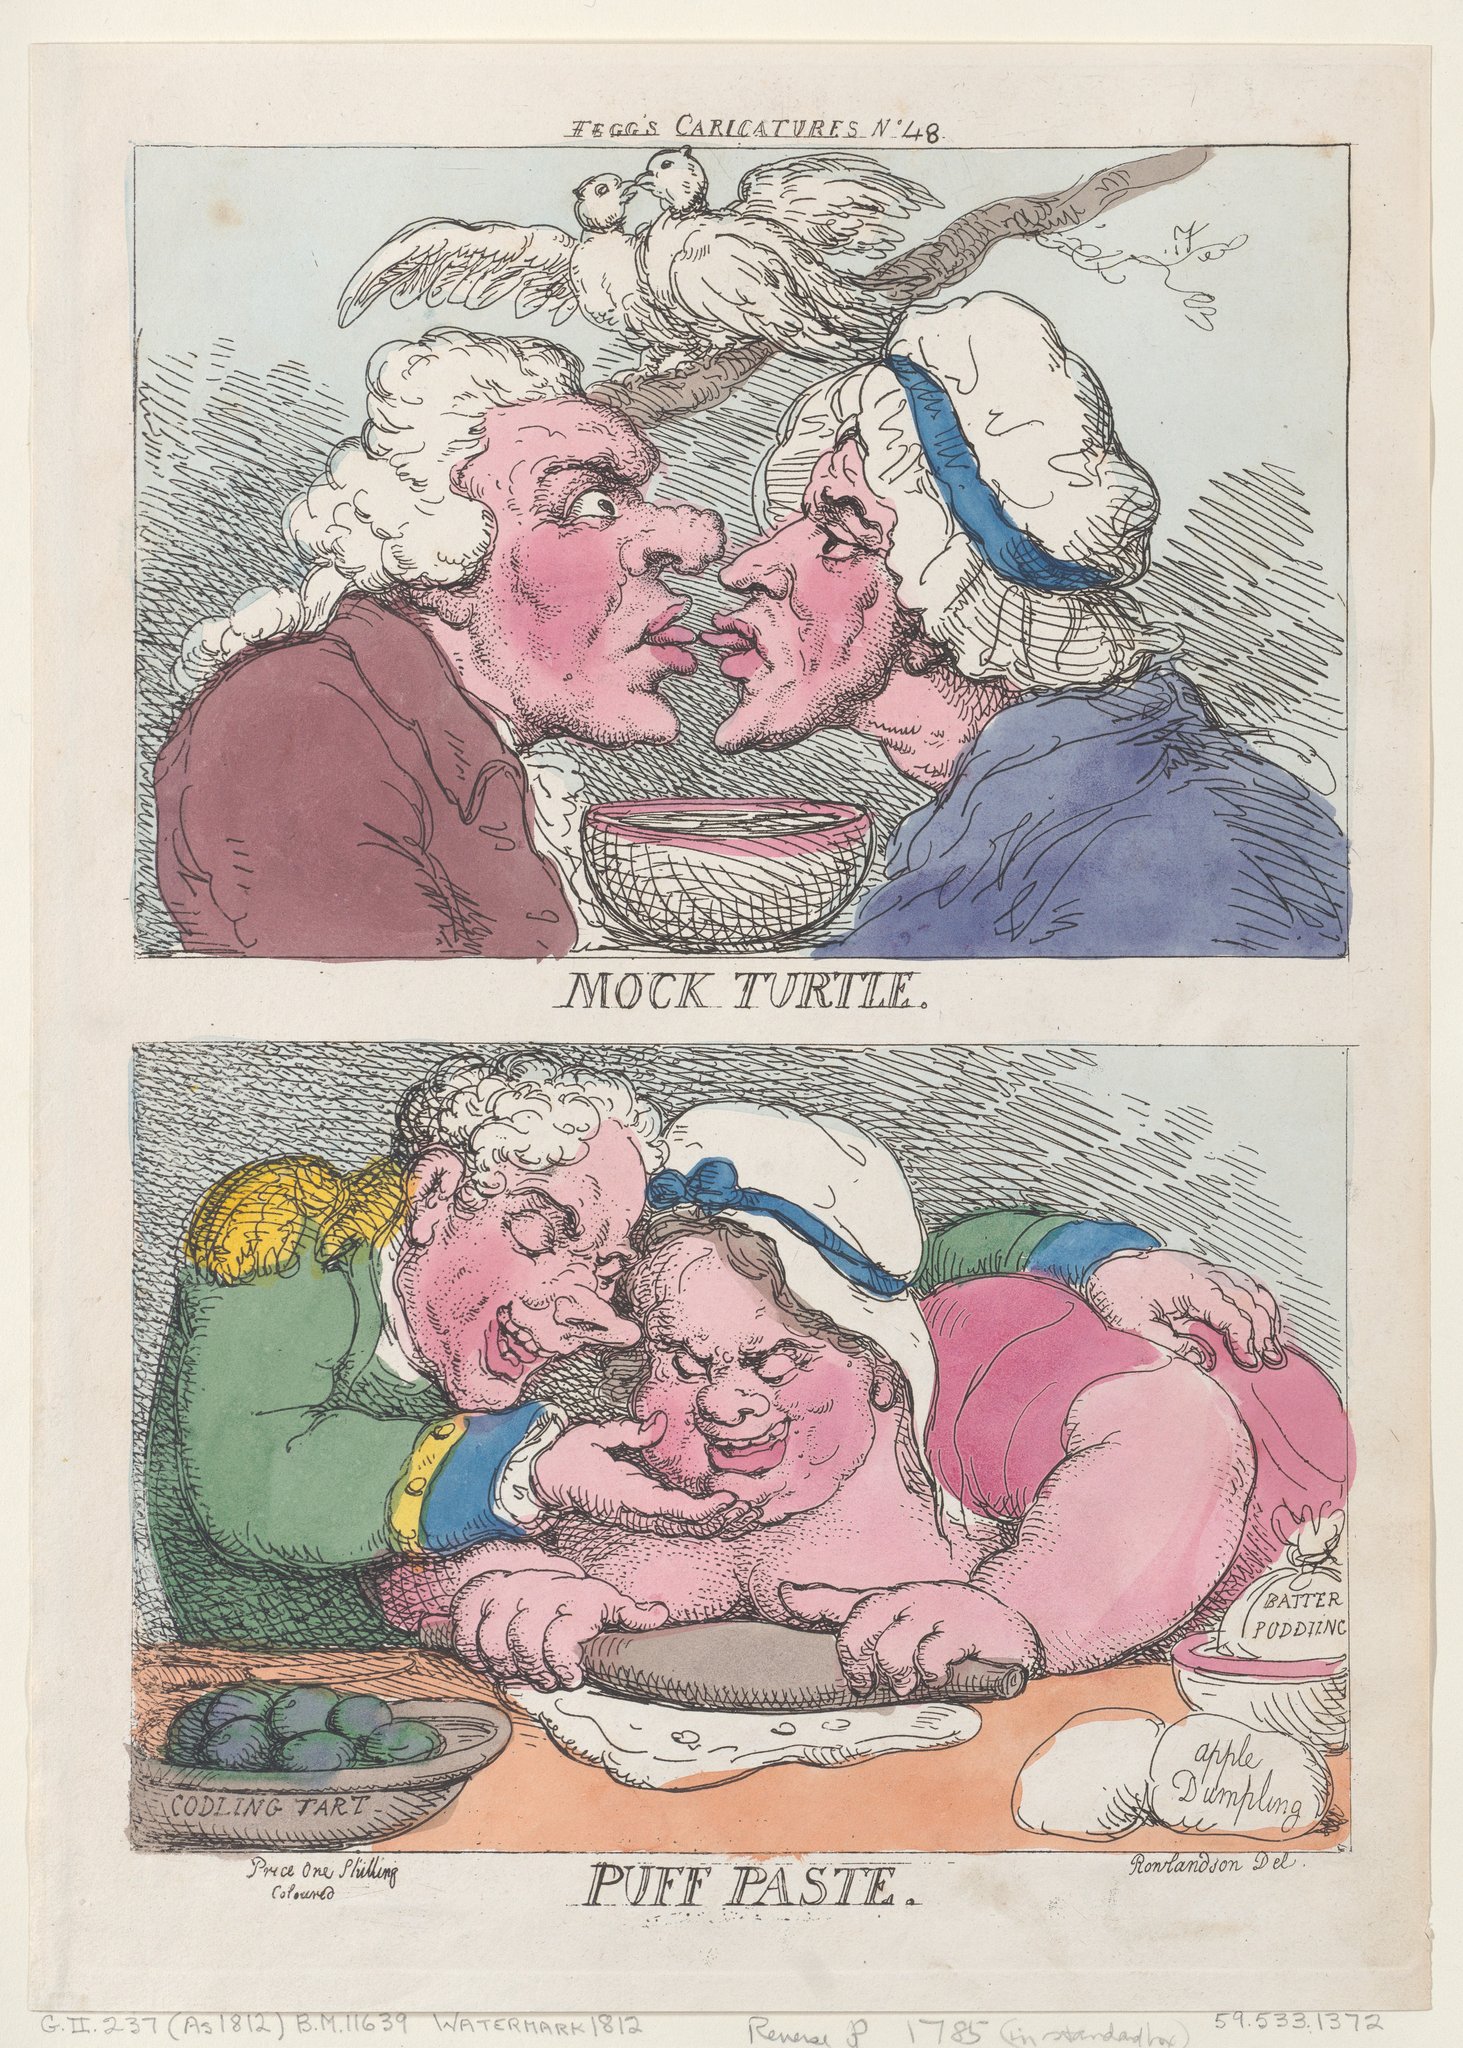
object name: print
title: Mock Turtle; Puff Paste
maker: thomas rowlandson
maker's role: artist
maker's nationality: british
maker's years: 1757-1827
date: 1812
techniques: etching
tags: satire,men,women